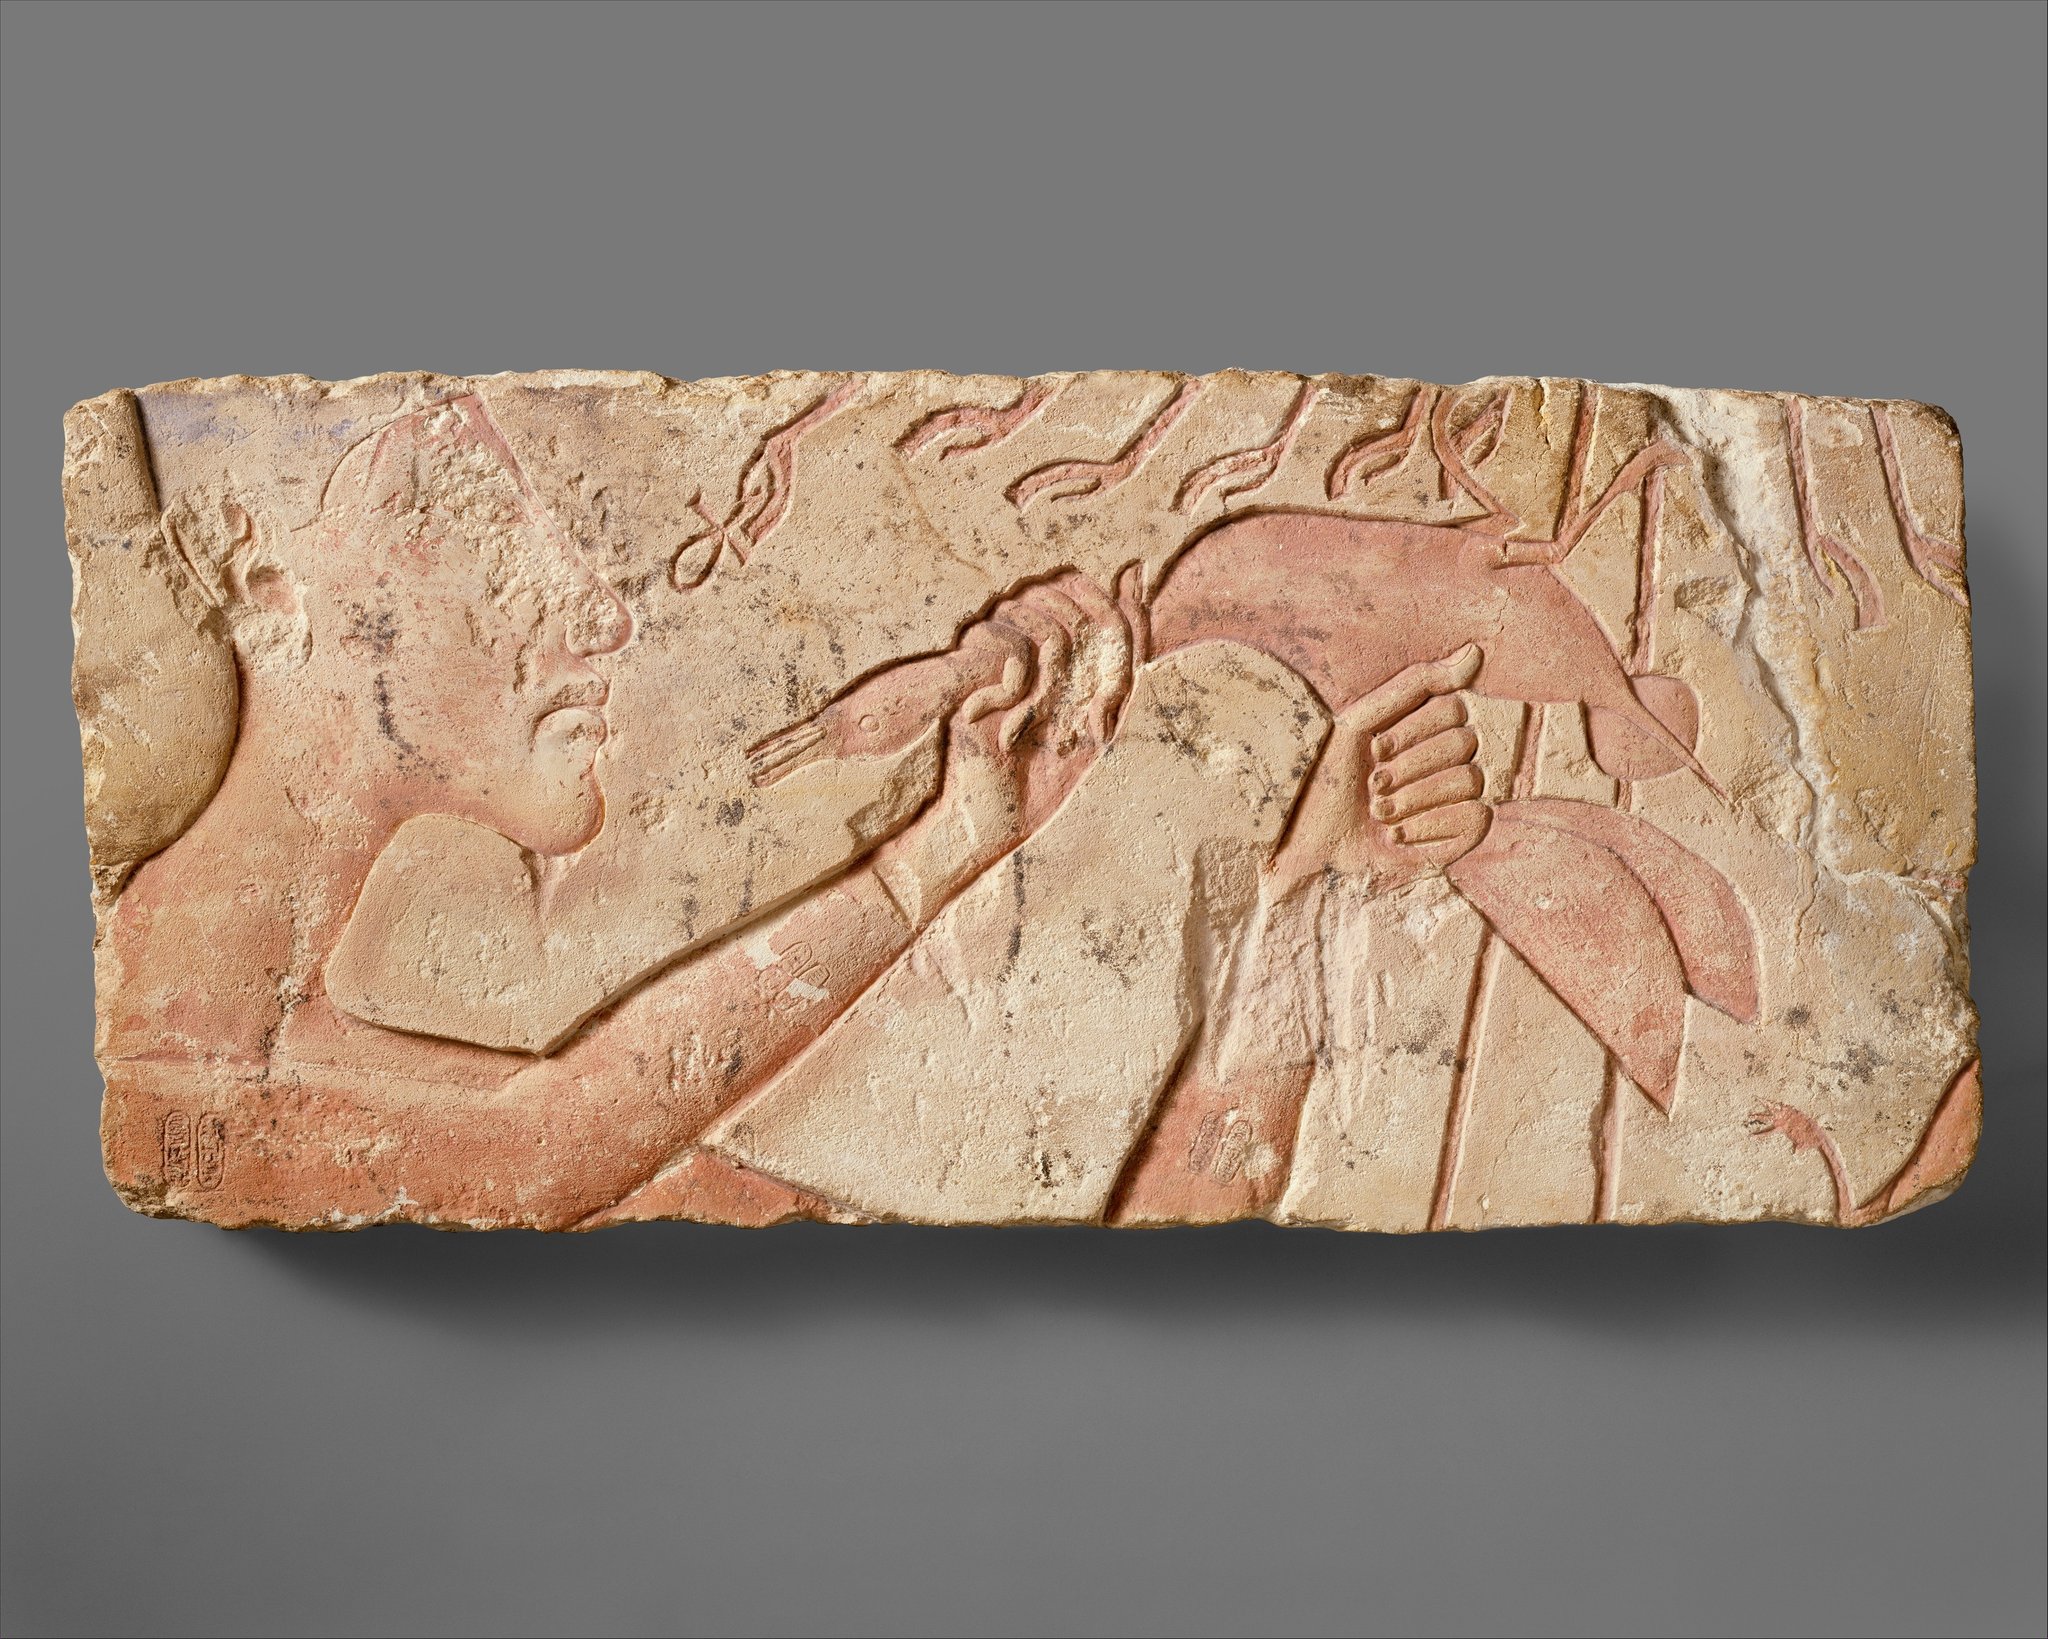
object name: talatat, akhenaten, duck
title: Akhenaten Sacrificing a Duck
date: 1353-1336 BCE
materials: limestone, paint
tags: ducks,men